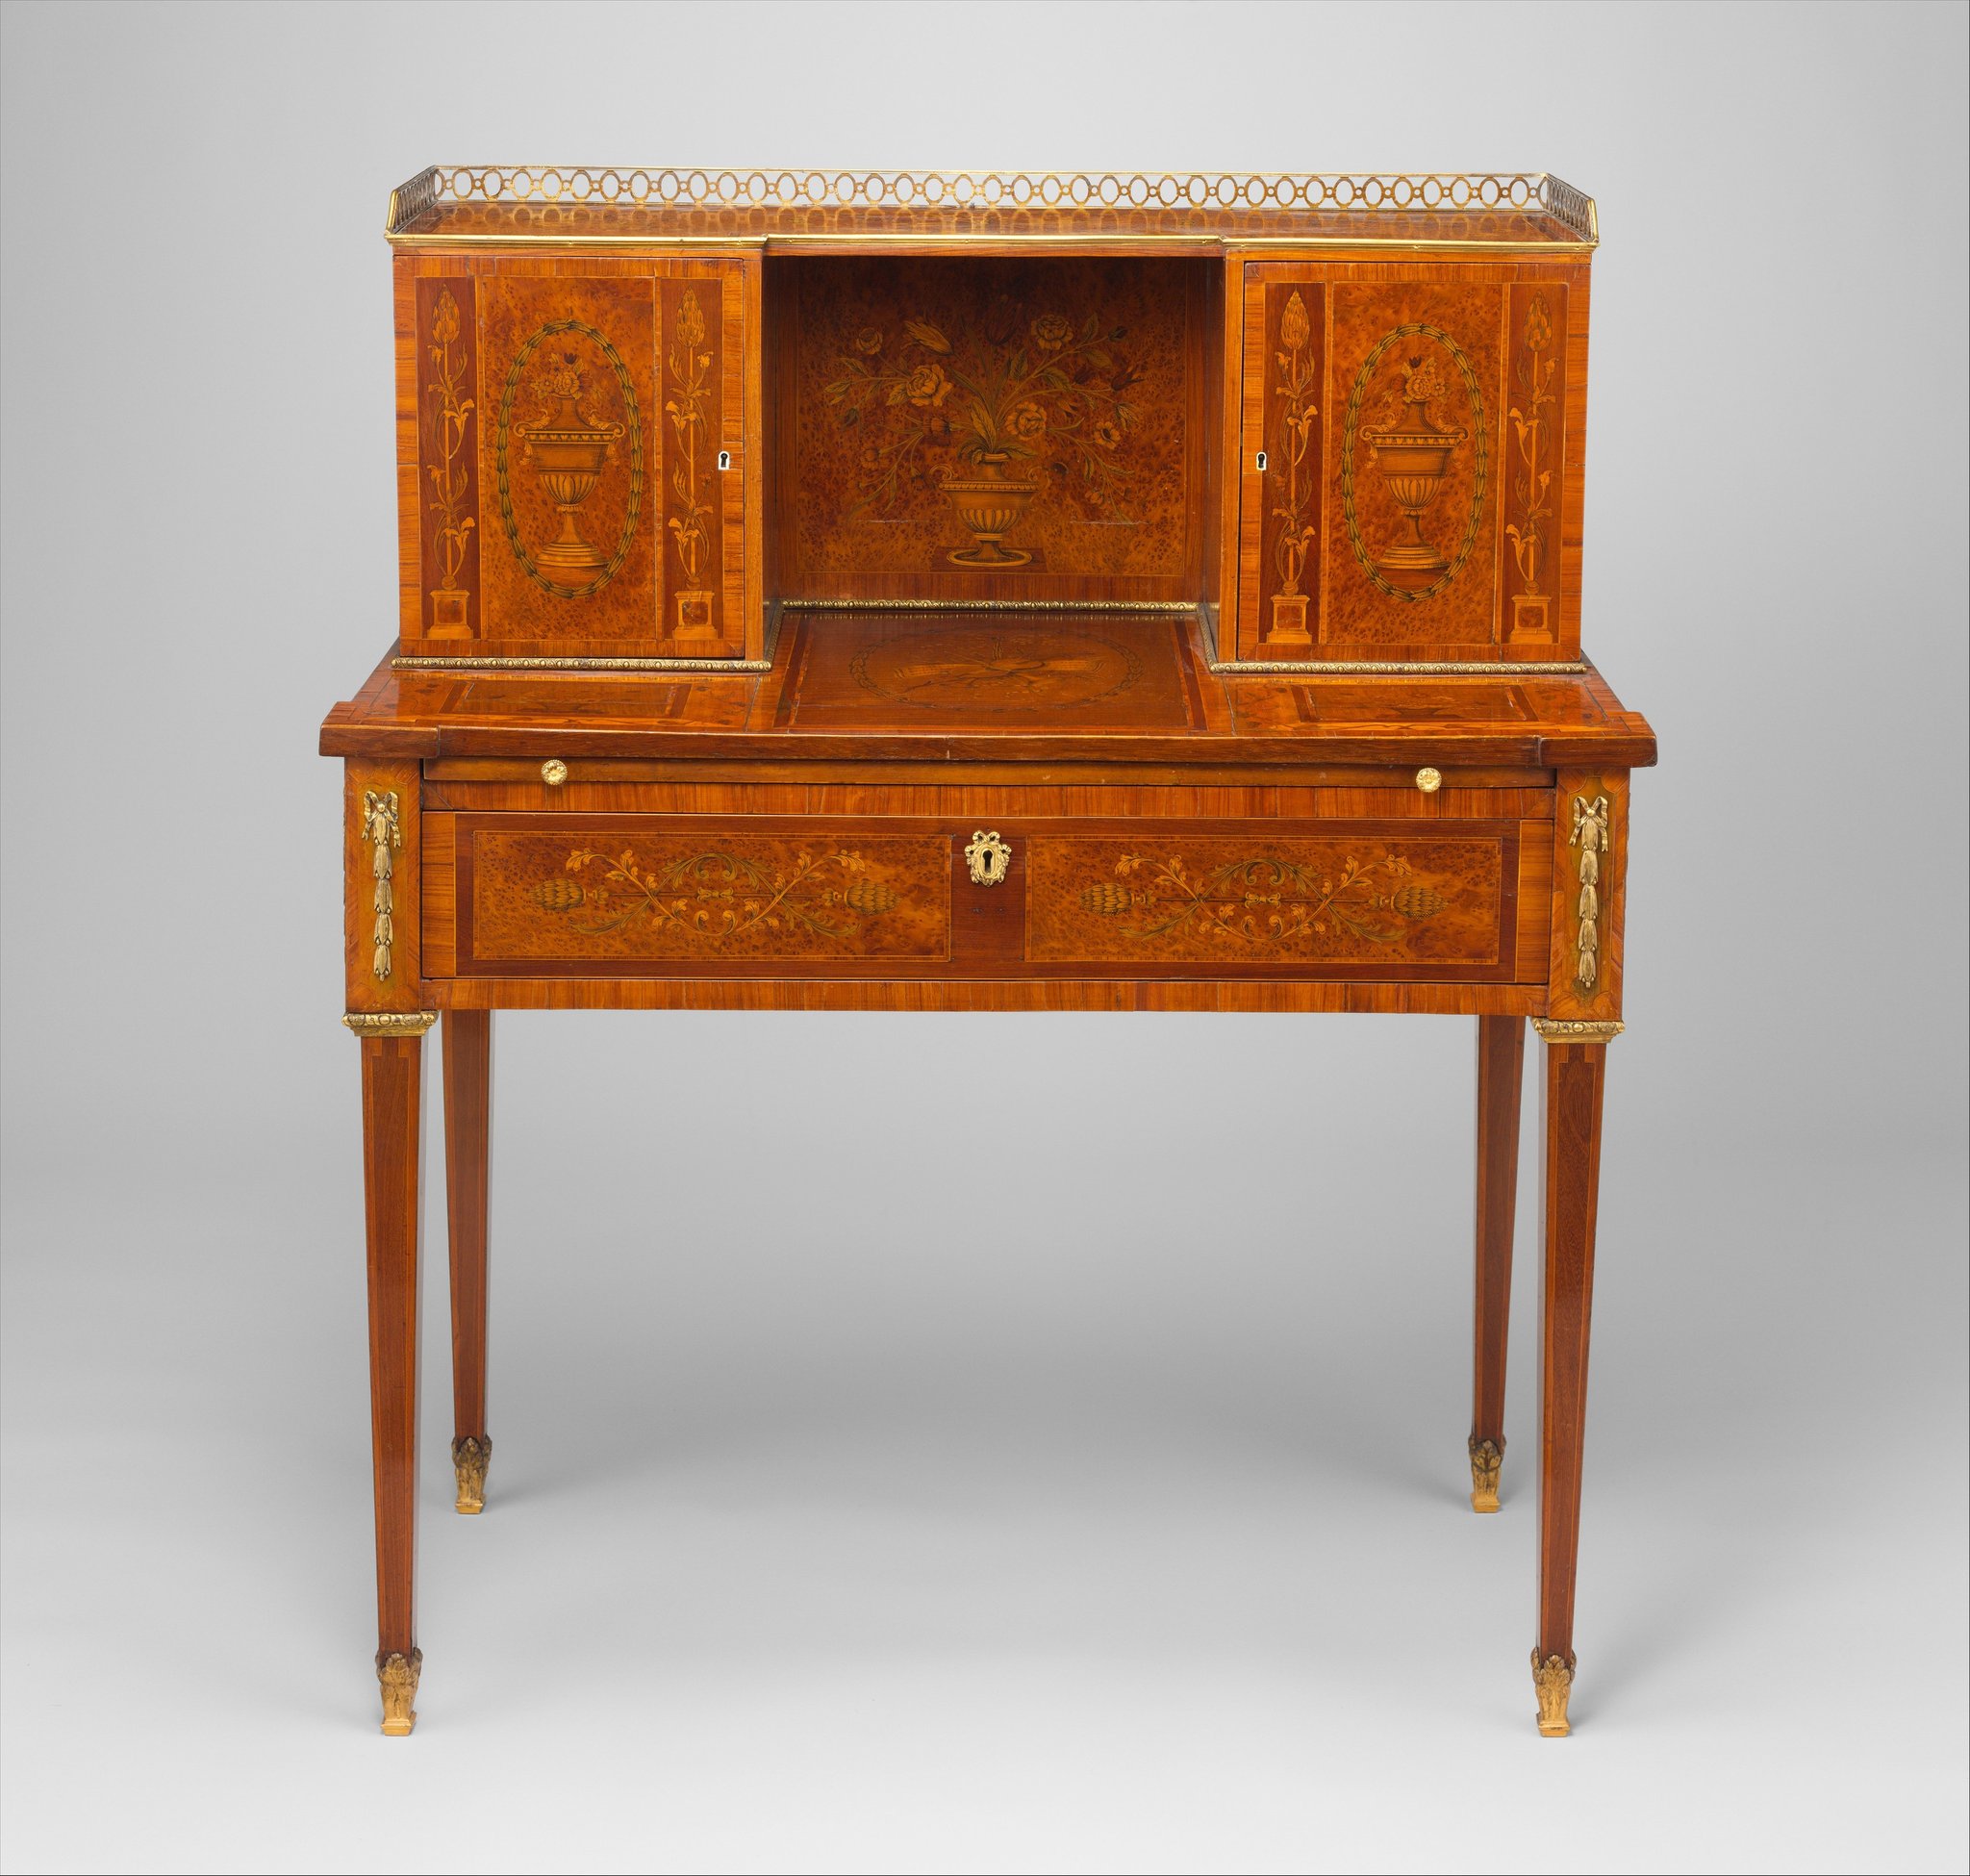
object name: desk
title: Desk (bonheur du jour)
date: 1780-1790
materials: wood, gilt bronze, ivory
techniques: stain, veneering